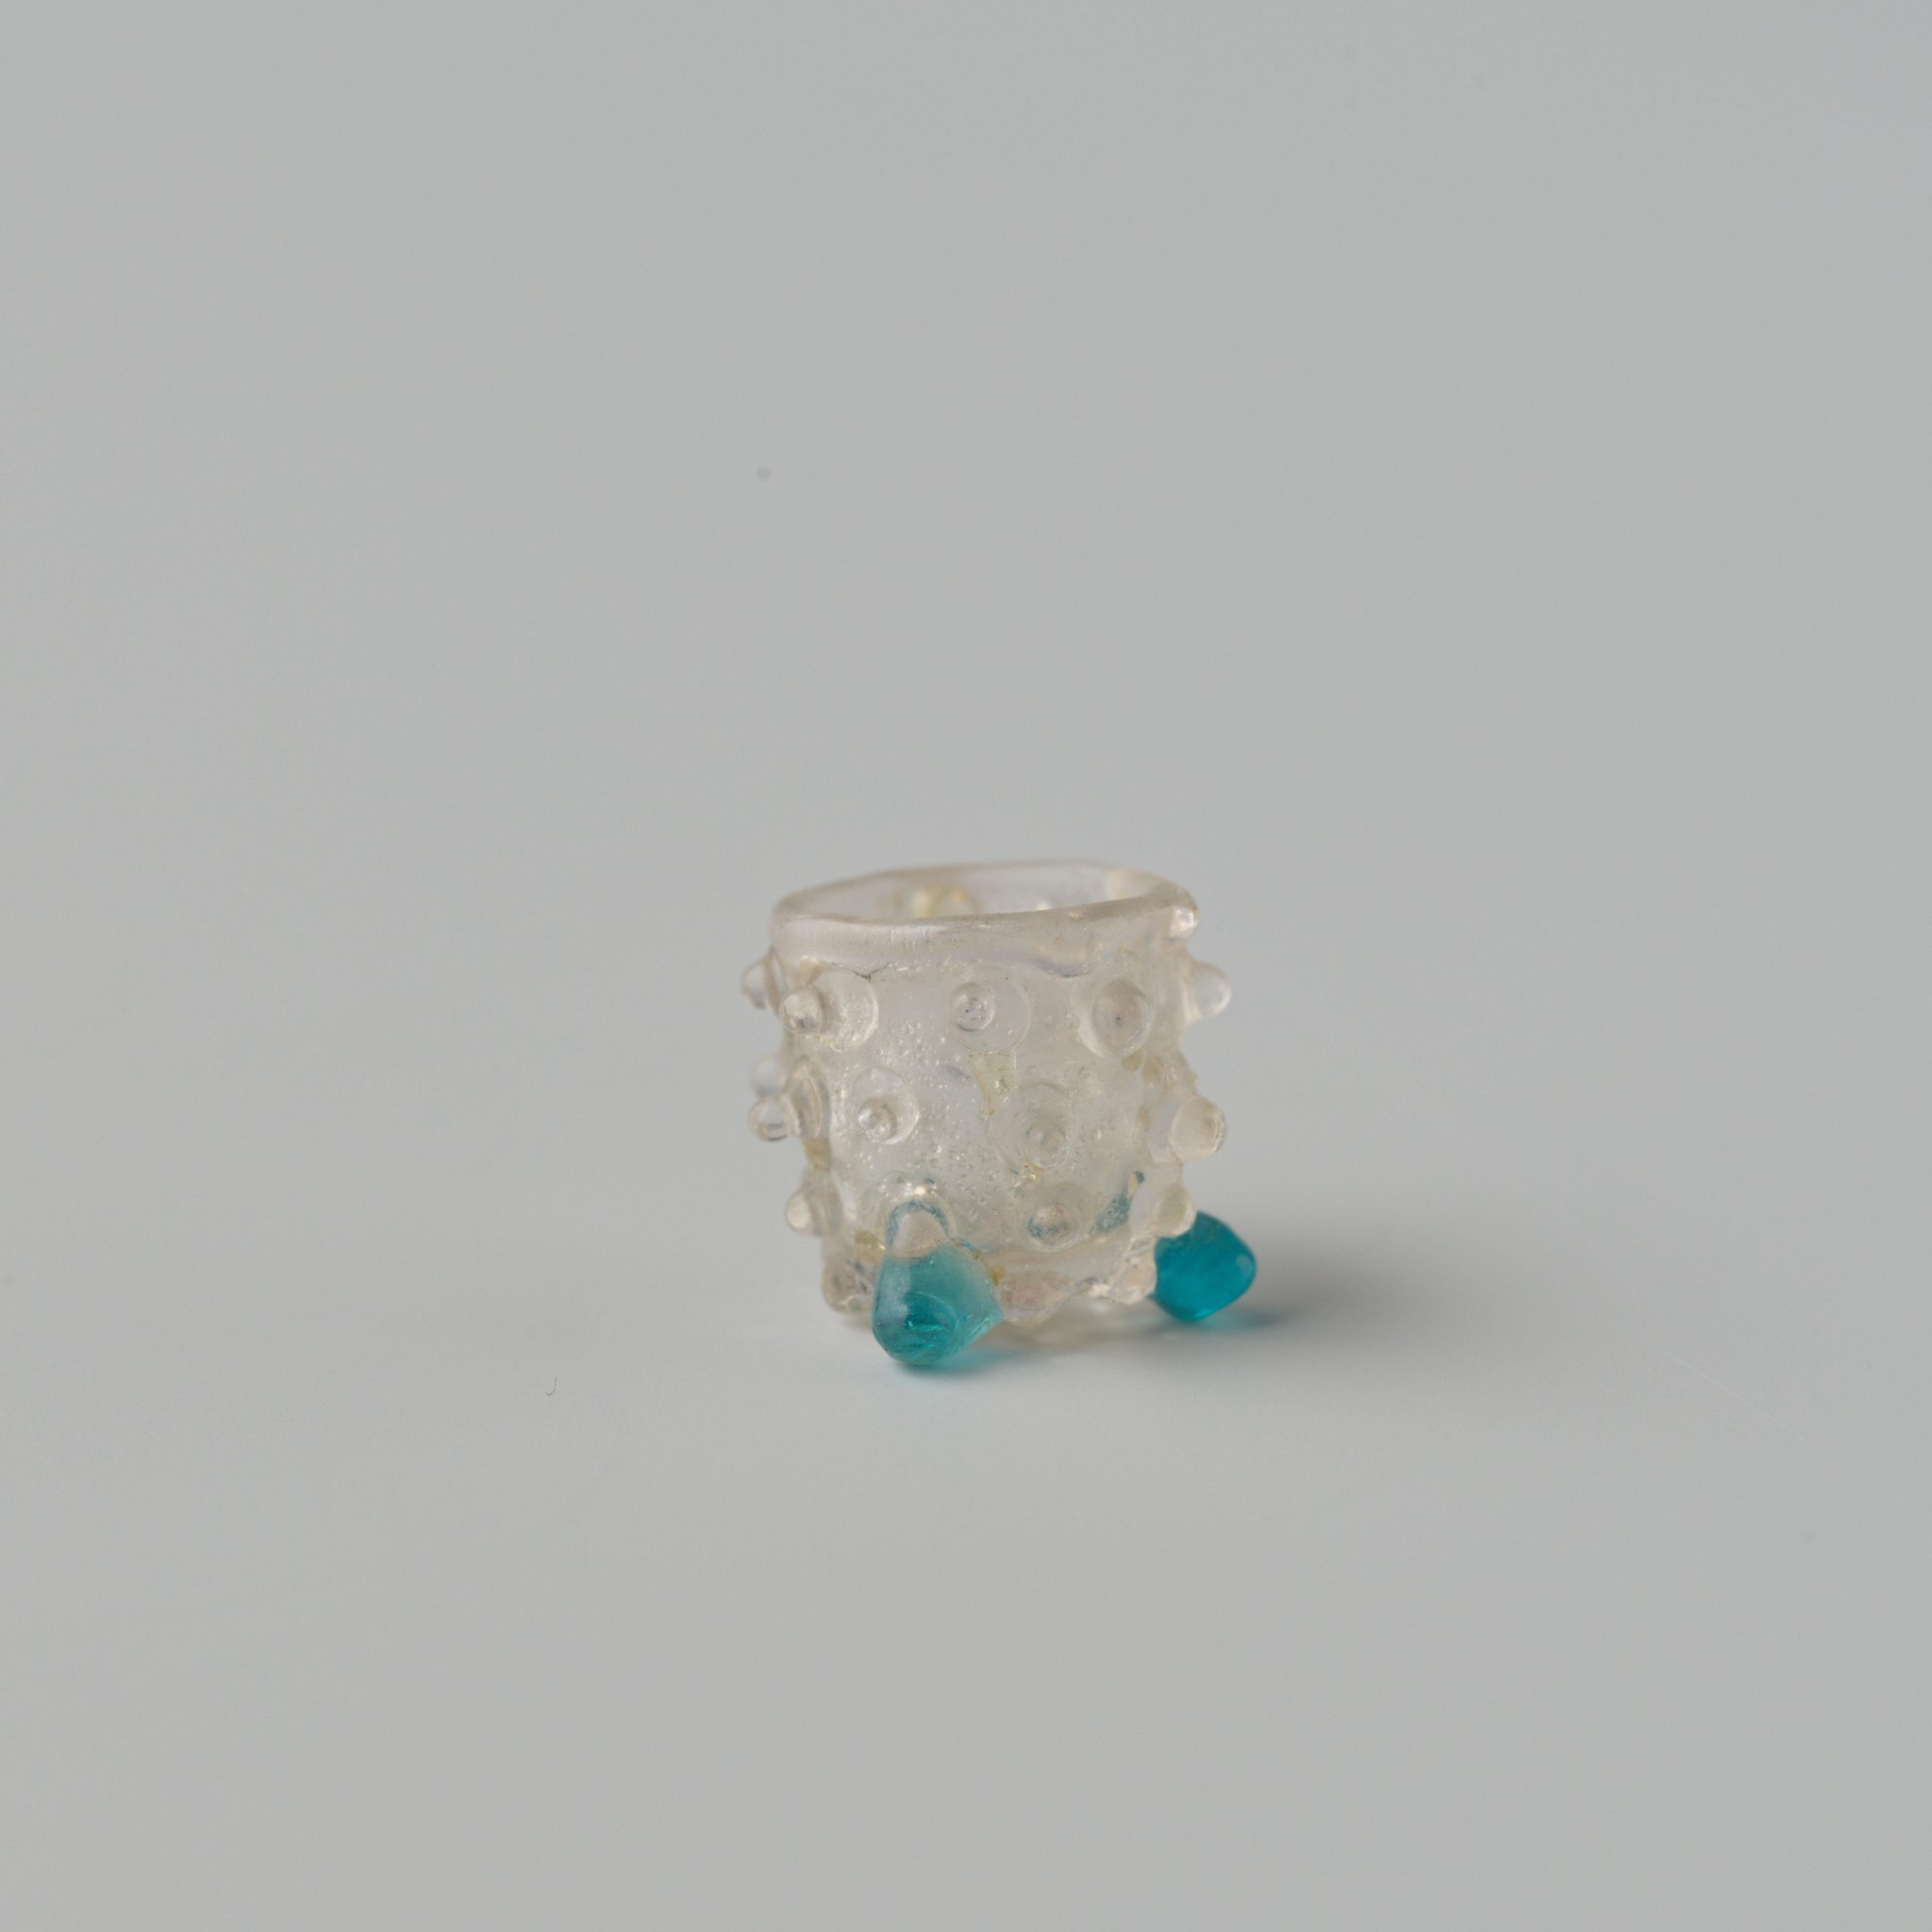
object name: cup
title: Beker van helder kleurloos glas versierd met noppen staand op drie bolpootjes.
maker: Anonymous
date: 1675-1710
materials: glass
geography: amsterdam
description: Bekertje van helder kleurloos glas versierd met noppen, staand op drie blauwe bolpootjes.